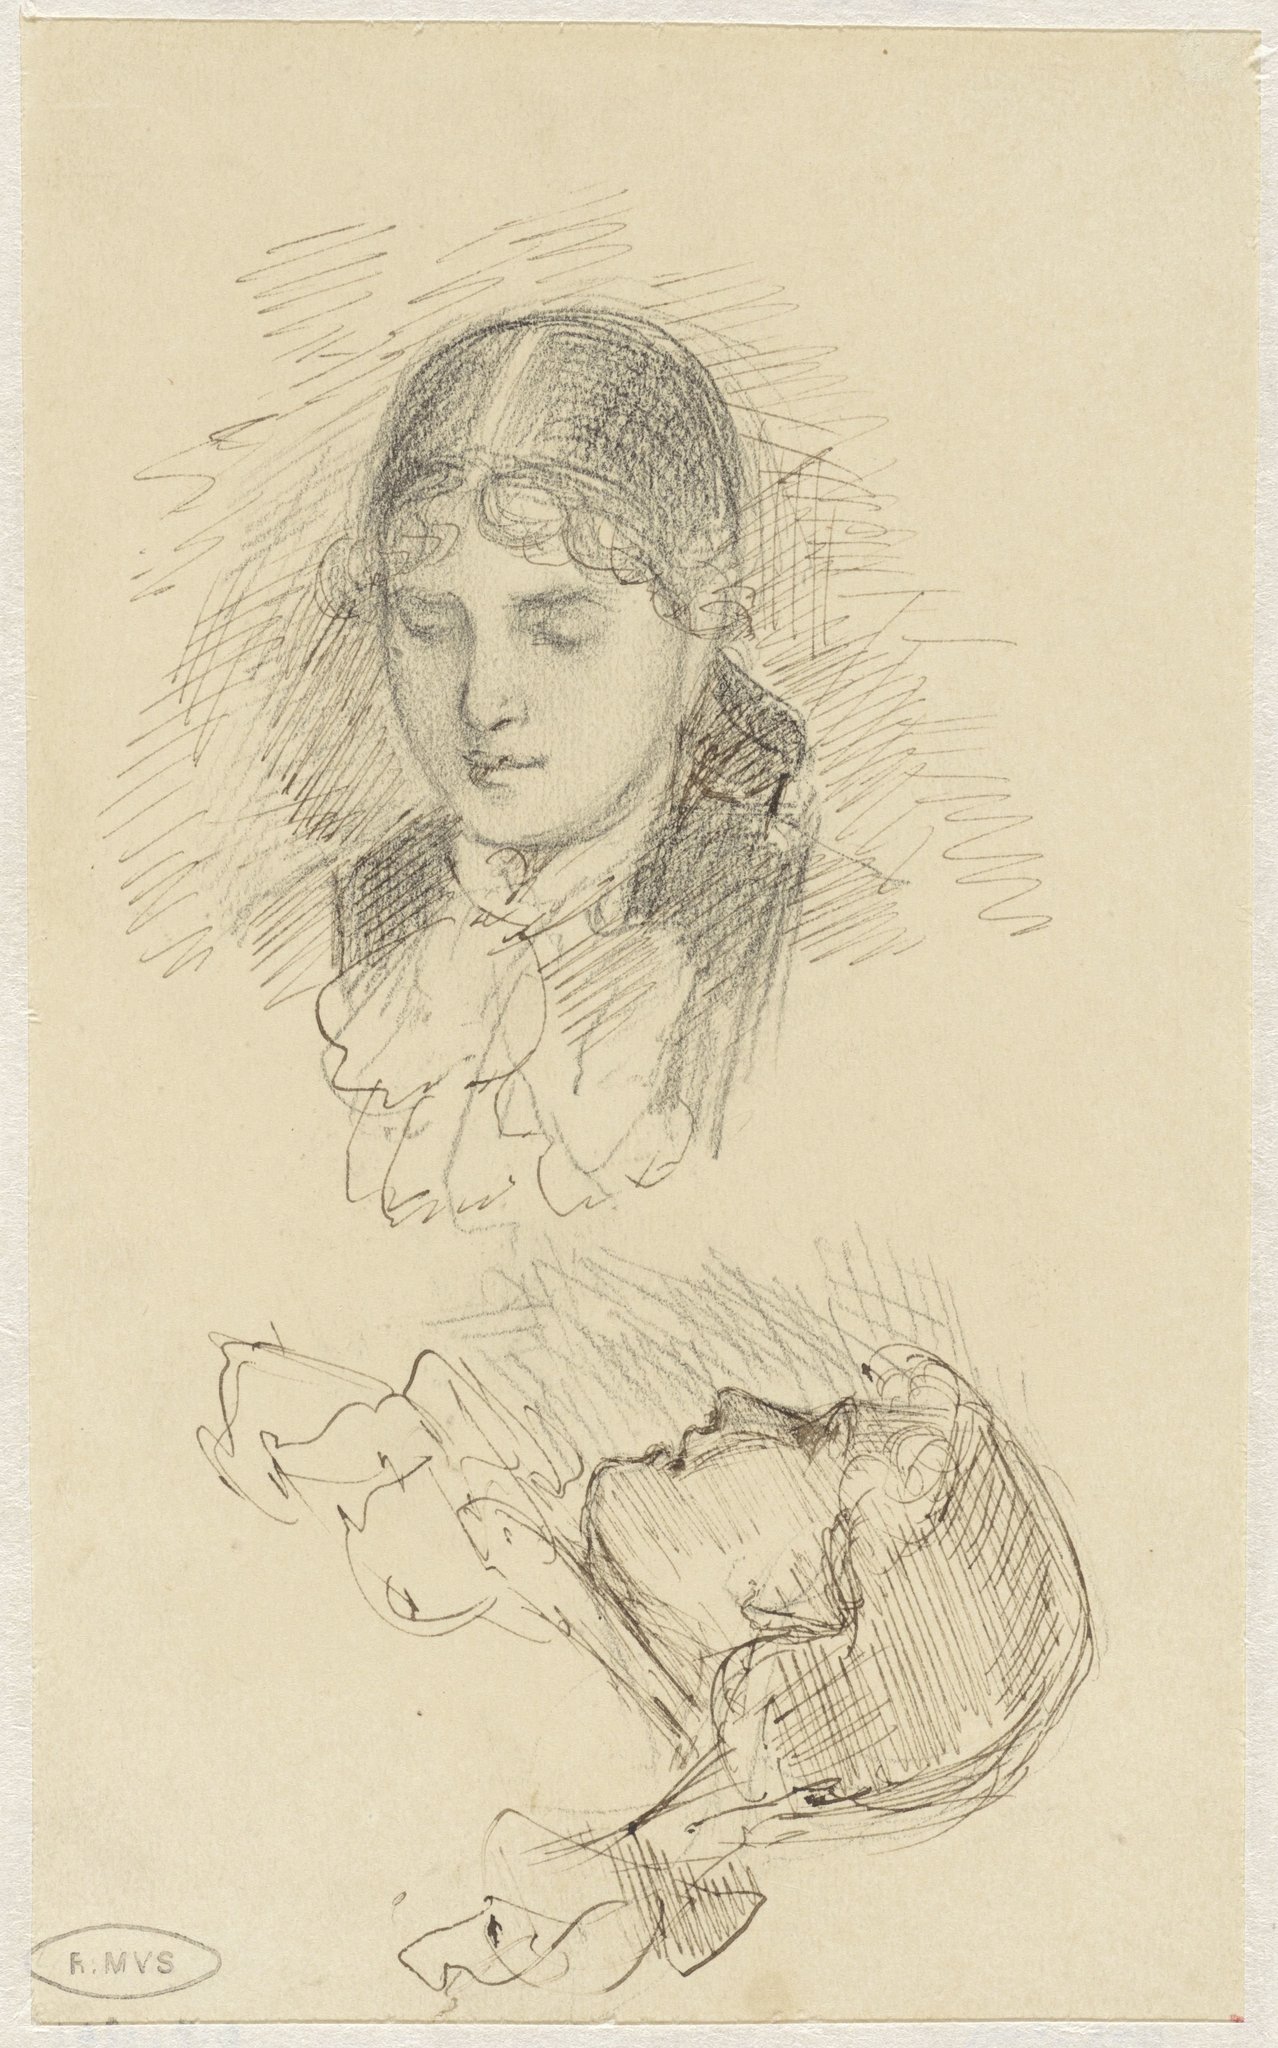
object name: drawing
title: Twee vrouwenhoofden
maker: jozef israëls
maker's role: draughtsman, painter, print maker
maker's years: 1824-1911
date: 1834-1911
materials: chalk, ink, paper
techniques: pen